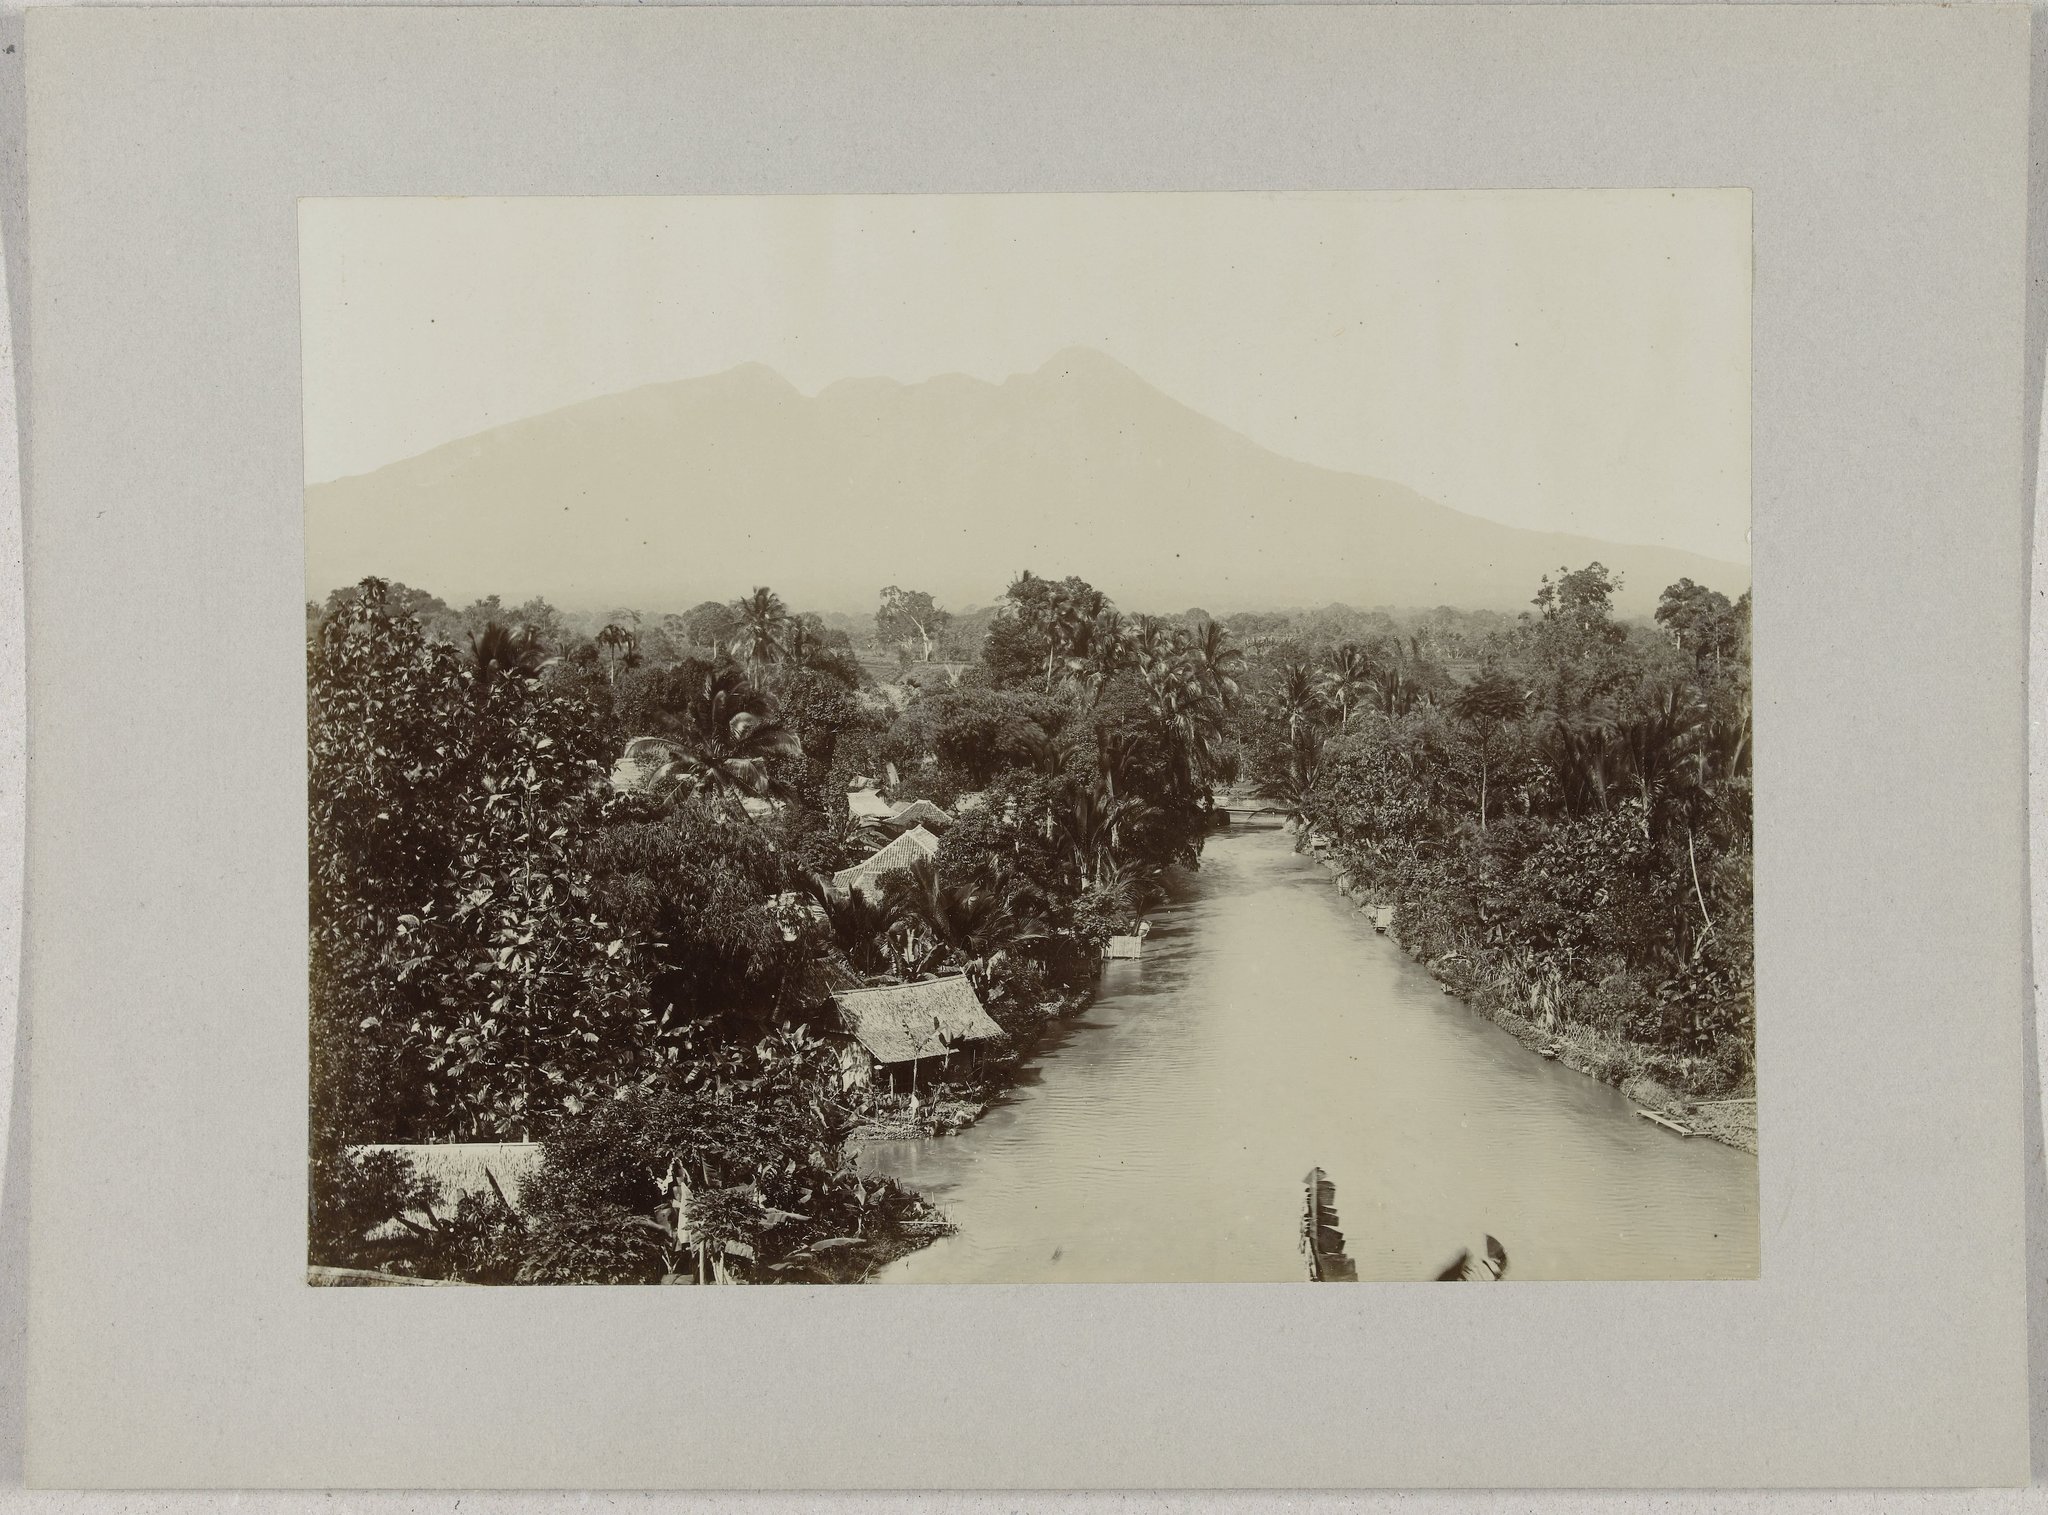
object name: photograph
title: 46. Buitenzorg: Salak met riviertje Tjidane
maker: Anonymous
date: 1895-1915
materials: cardboard, paper, photographic support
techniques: gelatin silver print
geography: buitenzorg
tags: salak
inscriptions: annotation: ‘46. Buitenzorg: Salak met riviertje Tjidane’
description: Landschap met de rivier Tjidane en de berg Salak, Buitenzorg (Bogor), Nederlands-Indië.